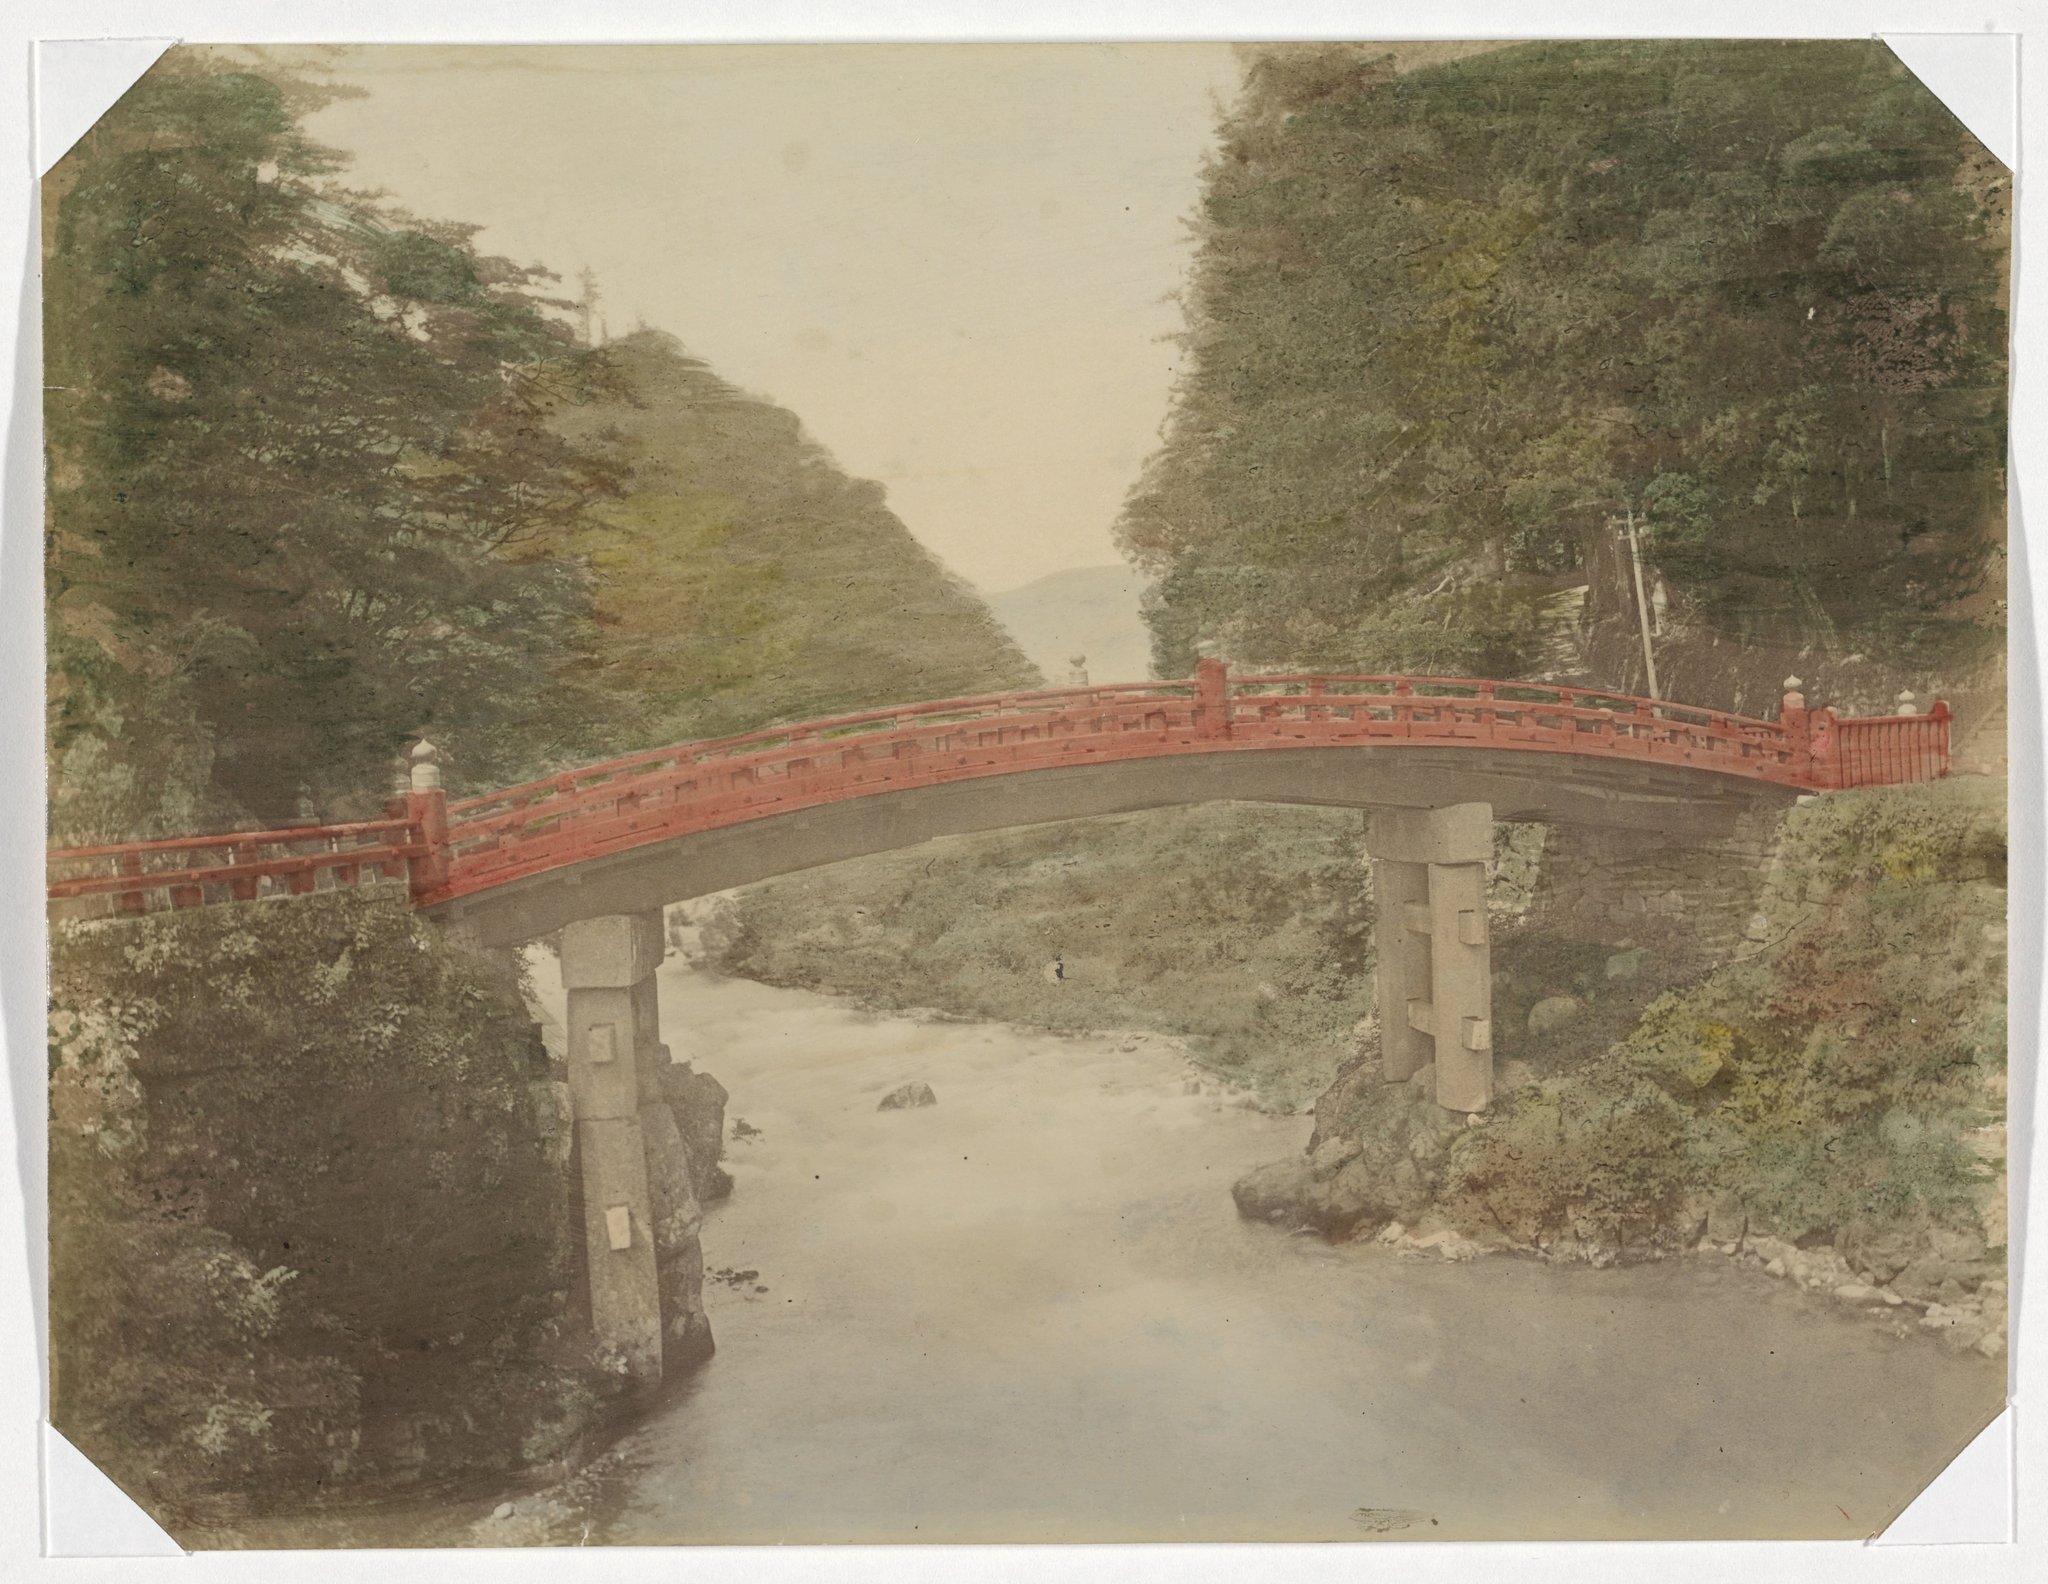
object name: photograph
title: Heilige brug in Nikko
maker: Anonymous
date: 1890-1894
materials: cardboard, paper, photographic support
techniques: albumen print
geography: nikko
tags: bridge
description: Onderdeel van Album met 69 foto's van een reis door Japan.